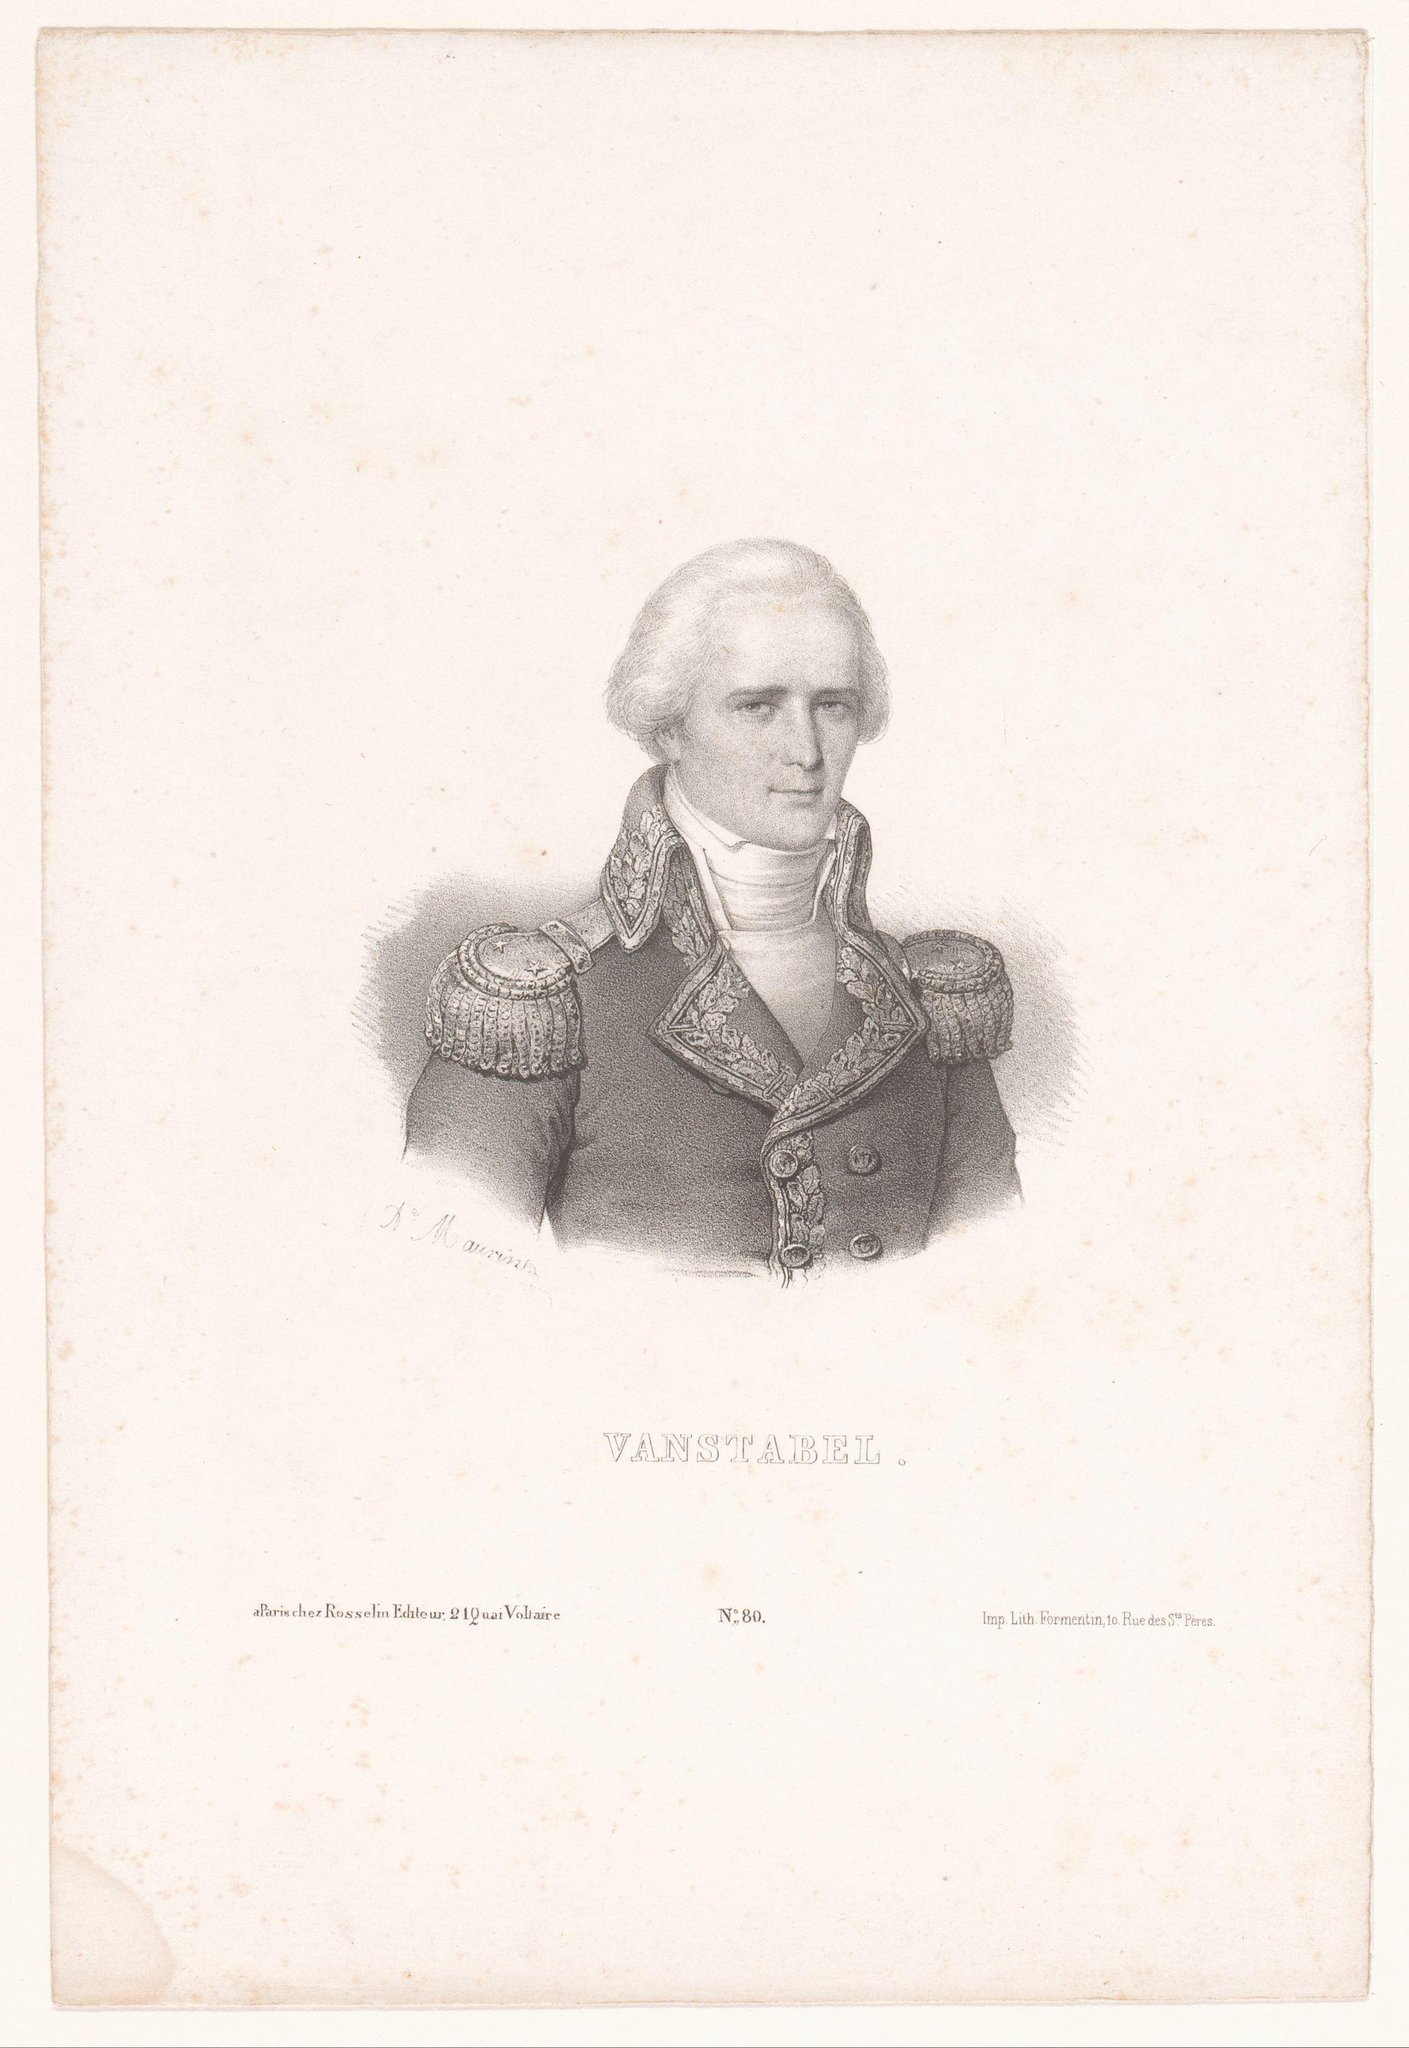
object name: print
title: Portret van Pierre Jean Van Stabel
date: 1830-1856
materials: paper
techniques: lithograph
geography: paris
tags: historical persons, officer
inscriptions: collector's mark: Lugt 2228